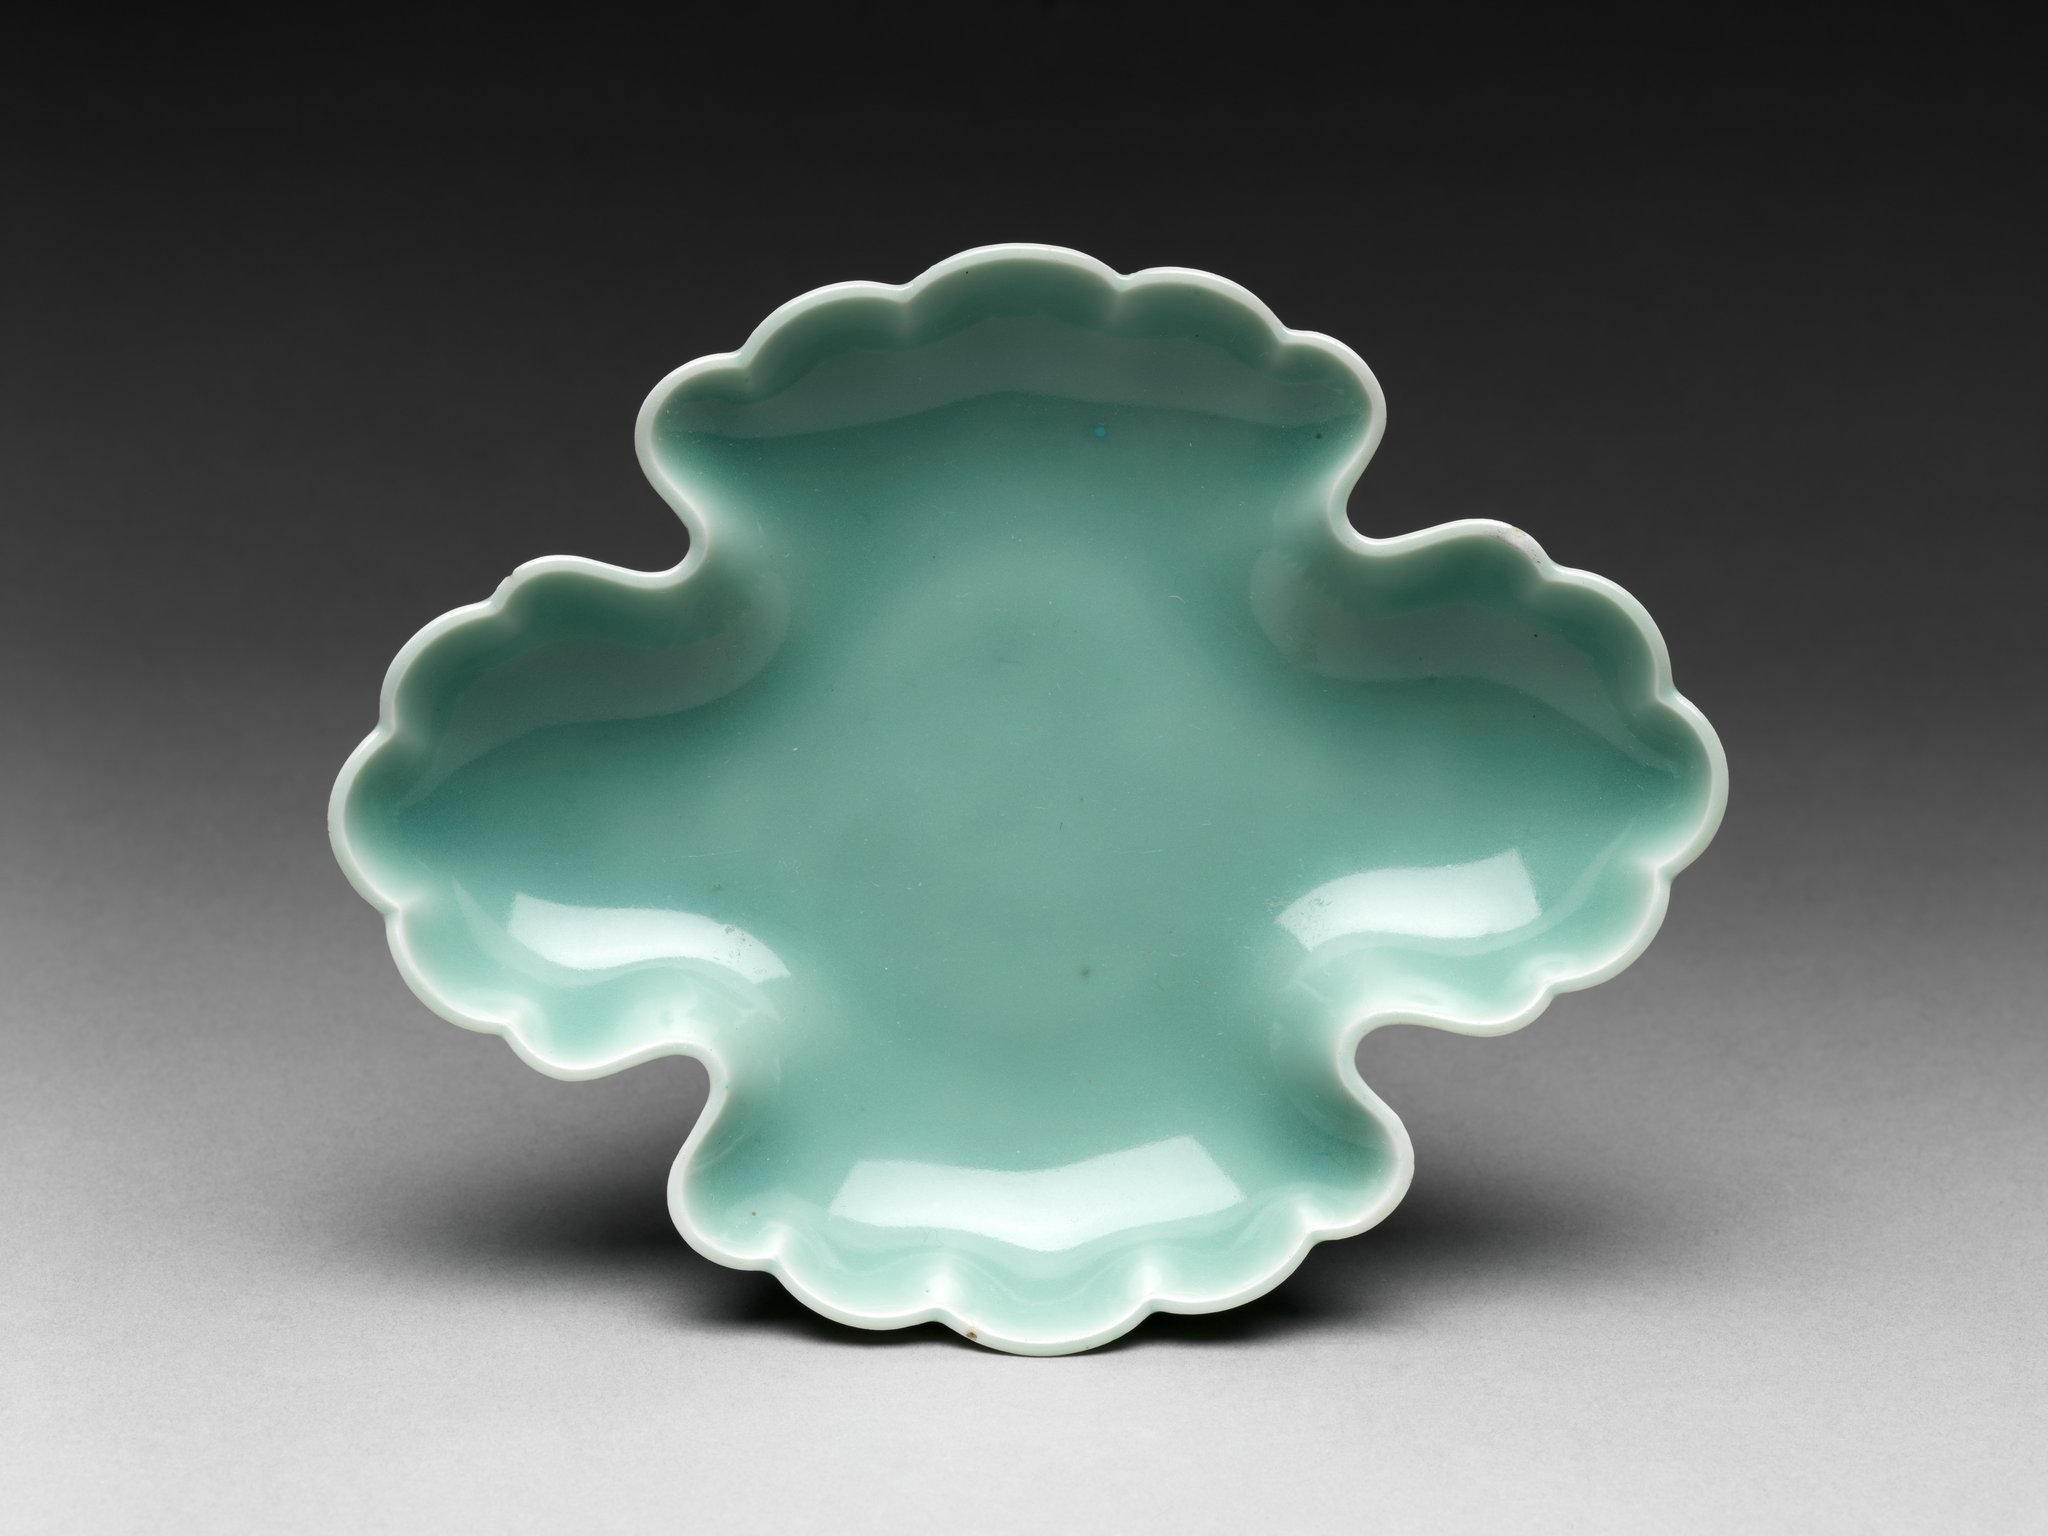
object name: dish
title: Lobed Dish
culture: japanese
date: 1701-1733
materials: ceramic glaze, glaze, porcelain